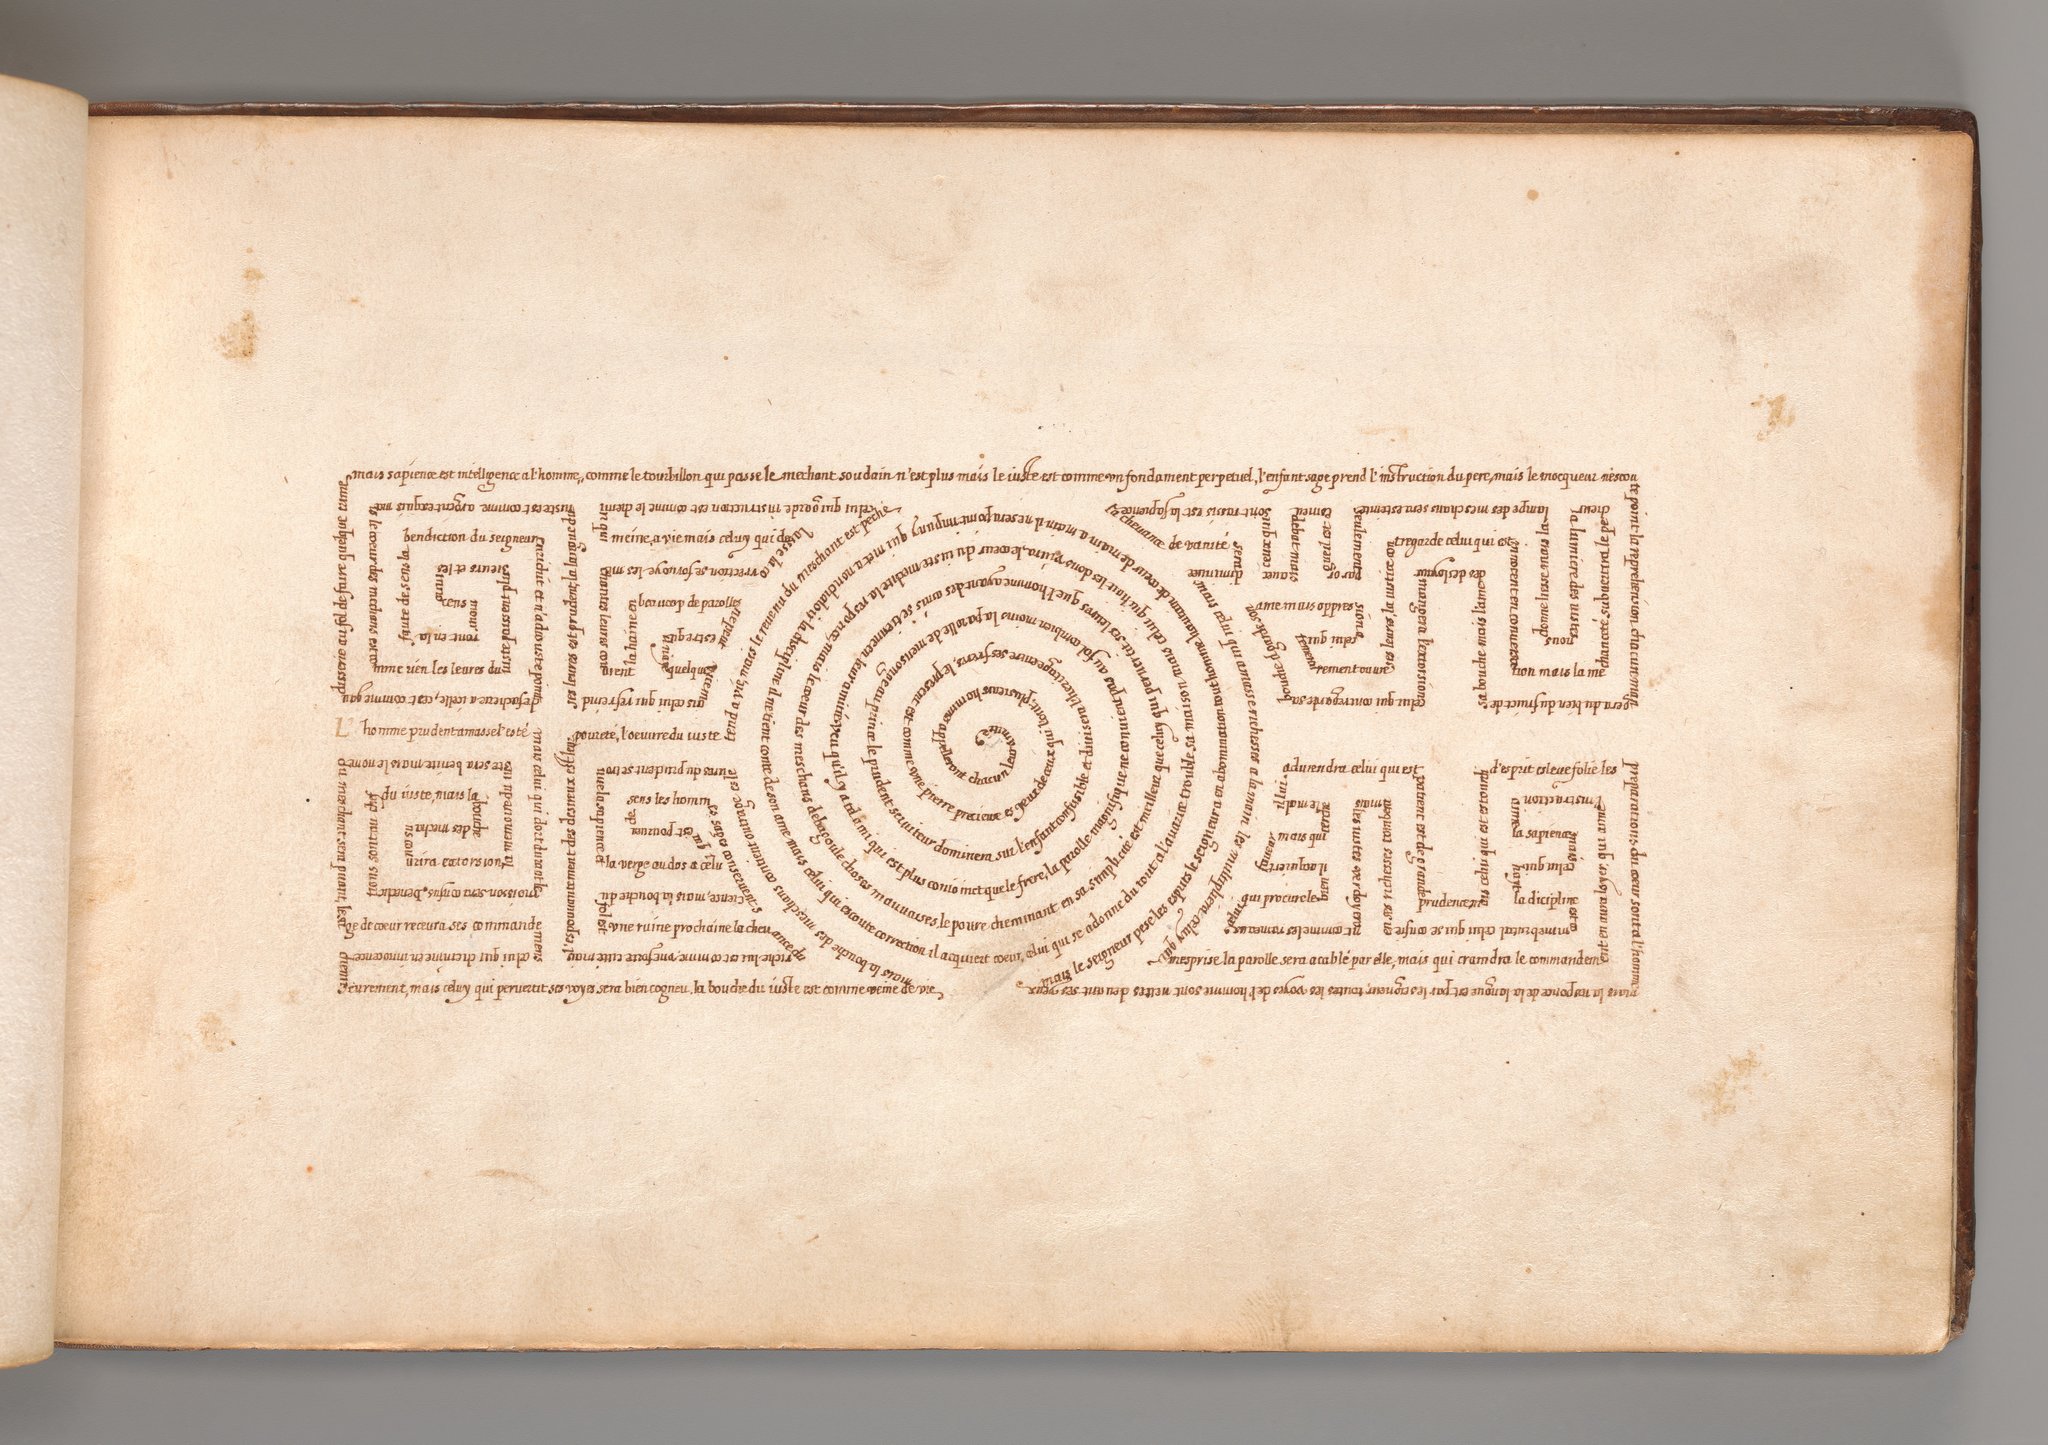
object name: album print ornament architecture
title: Micrographic Design in the Shape of a Labyrinth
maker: Anonymous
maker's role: artist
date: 1601-1633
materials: ink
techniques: pen